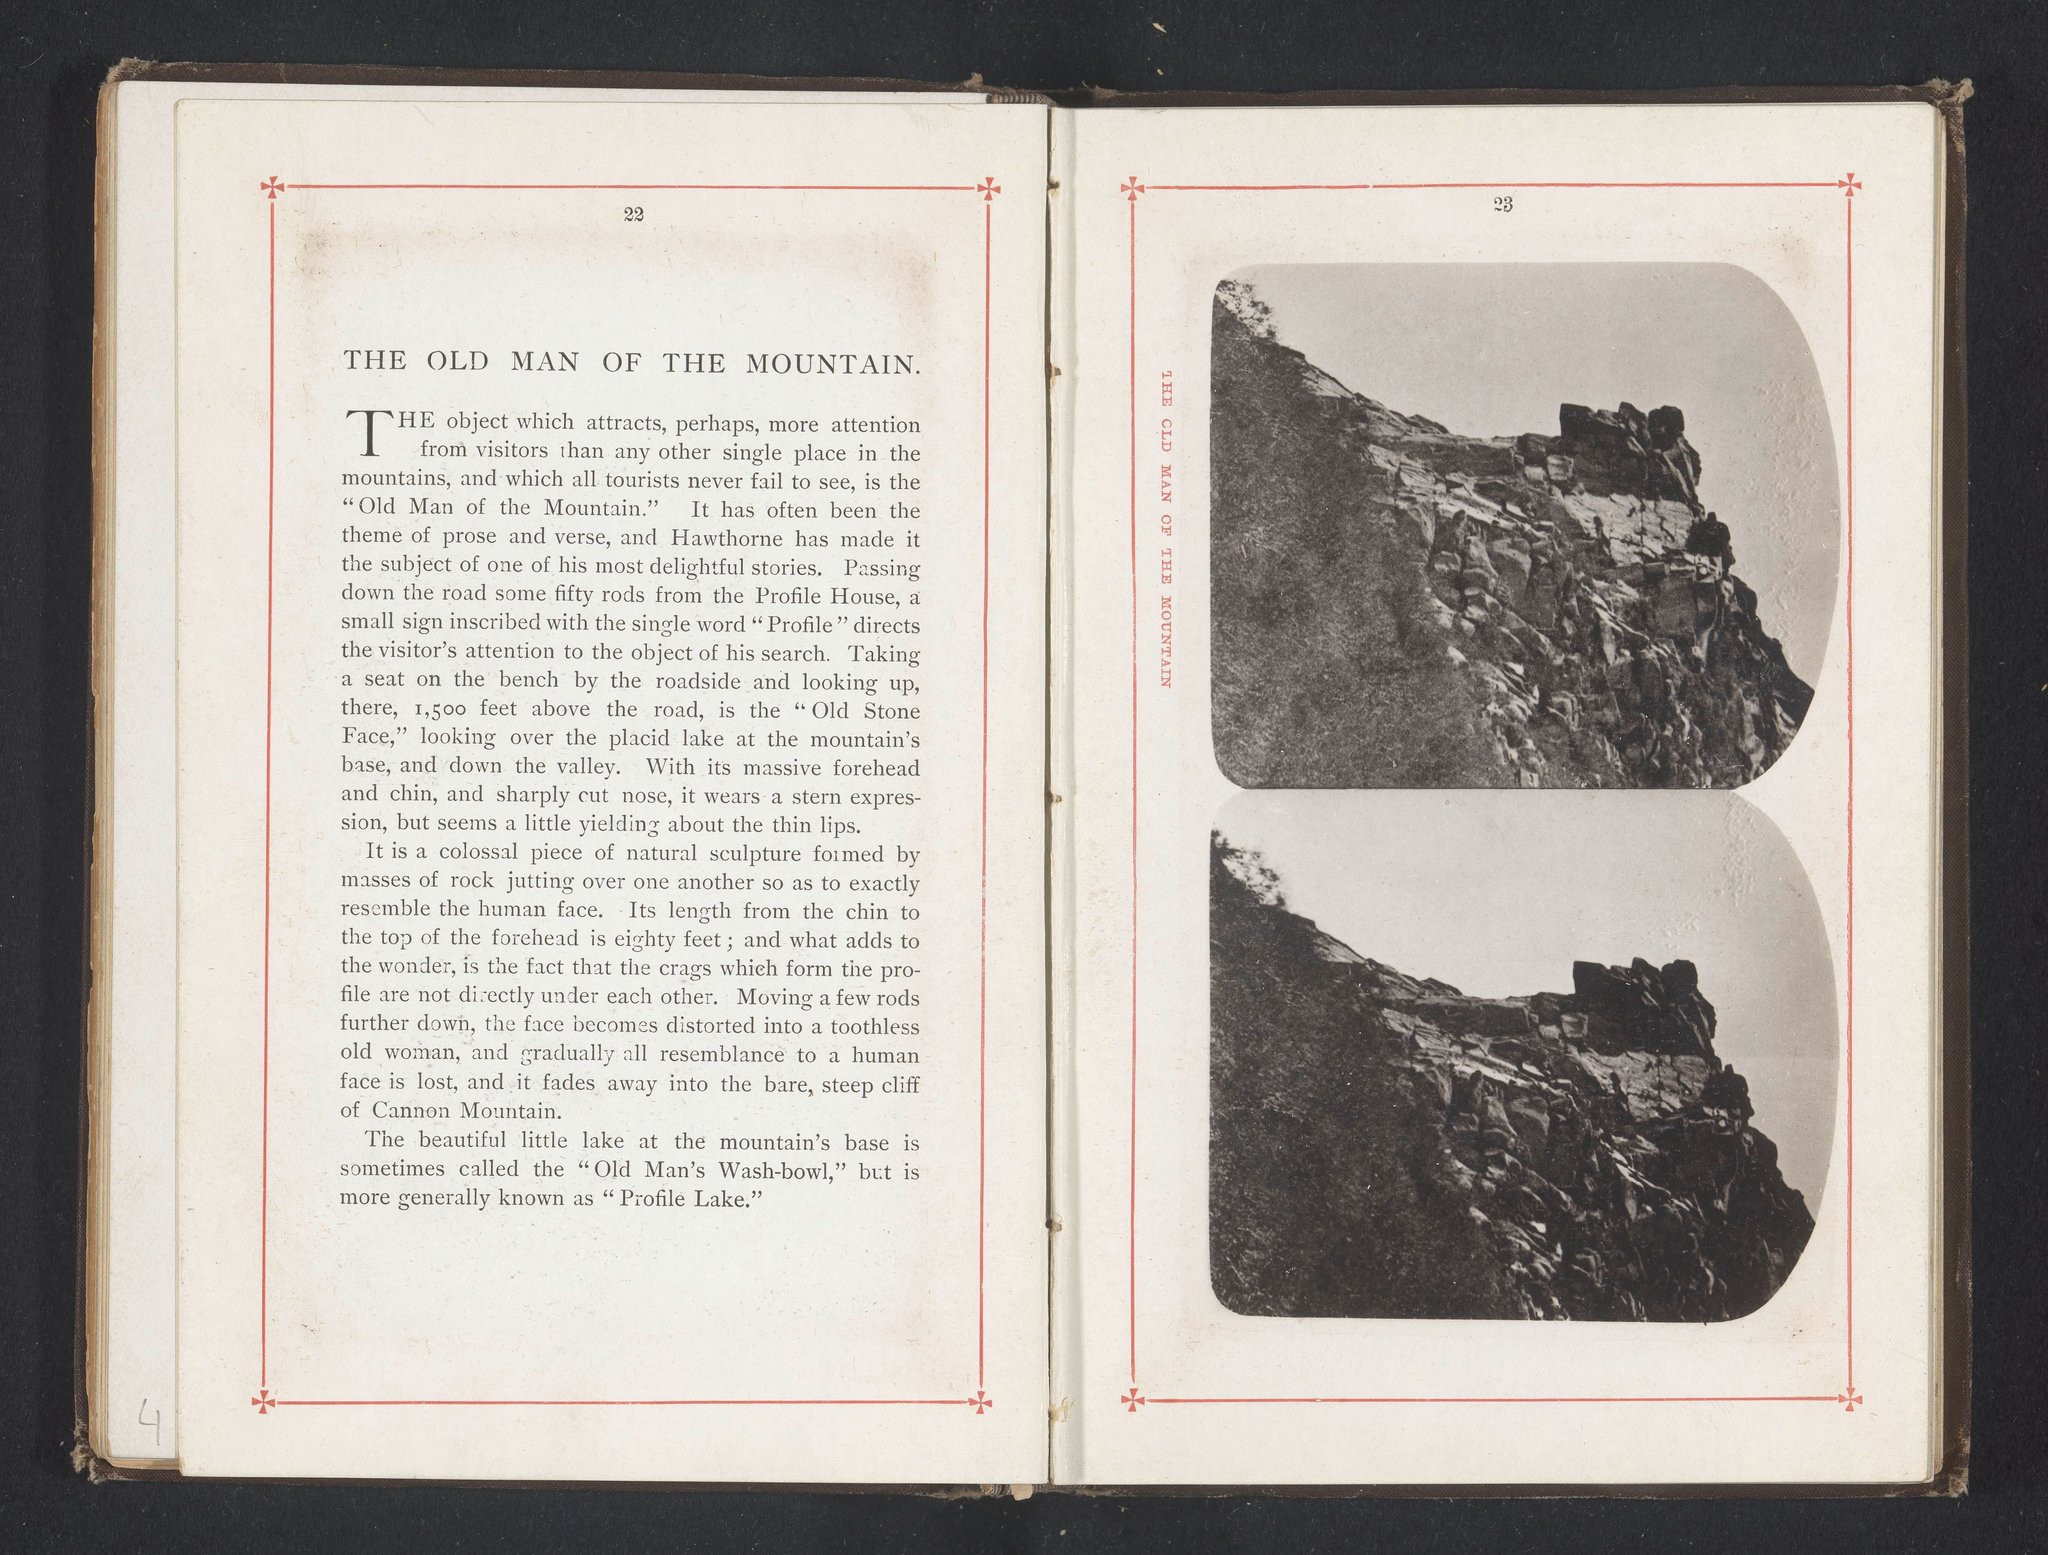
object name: stereograph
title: Gezicht op rotsformatie The Watcher in het Franconia Notch State Park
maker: Anonymous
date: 1873-1878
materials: paper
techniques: photograph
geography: franconia notch state park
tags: rock-formations, mountains